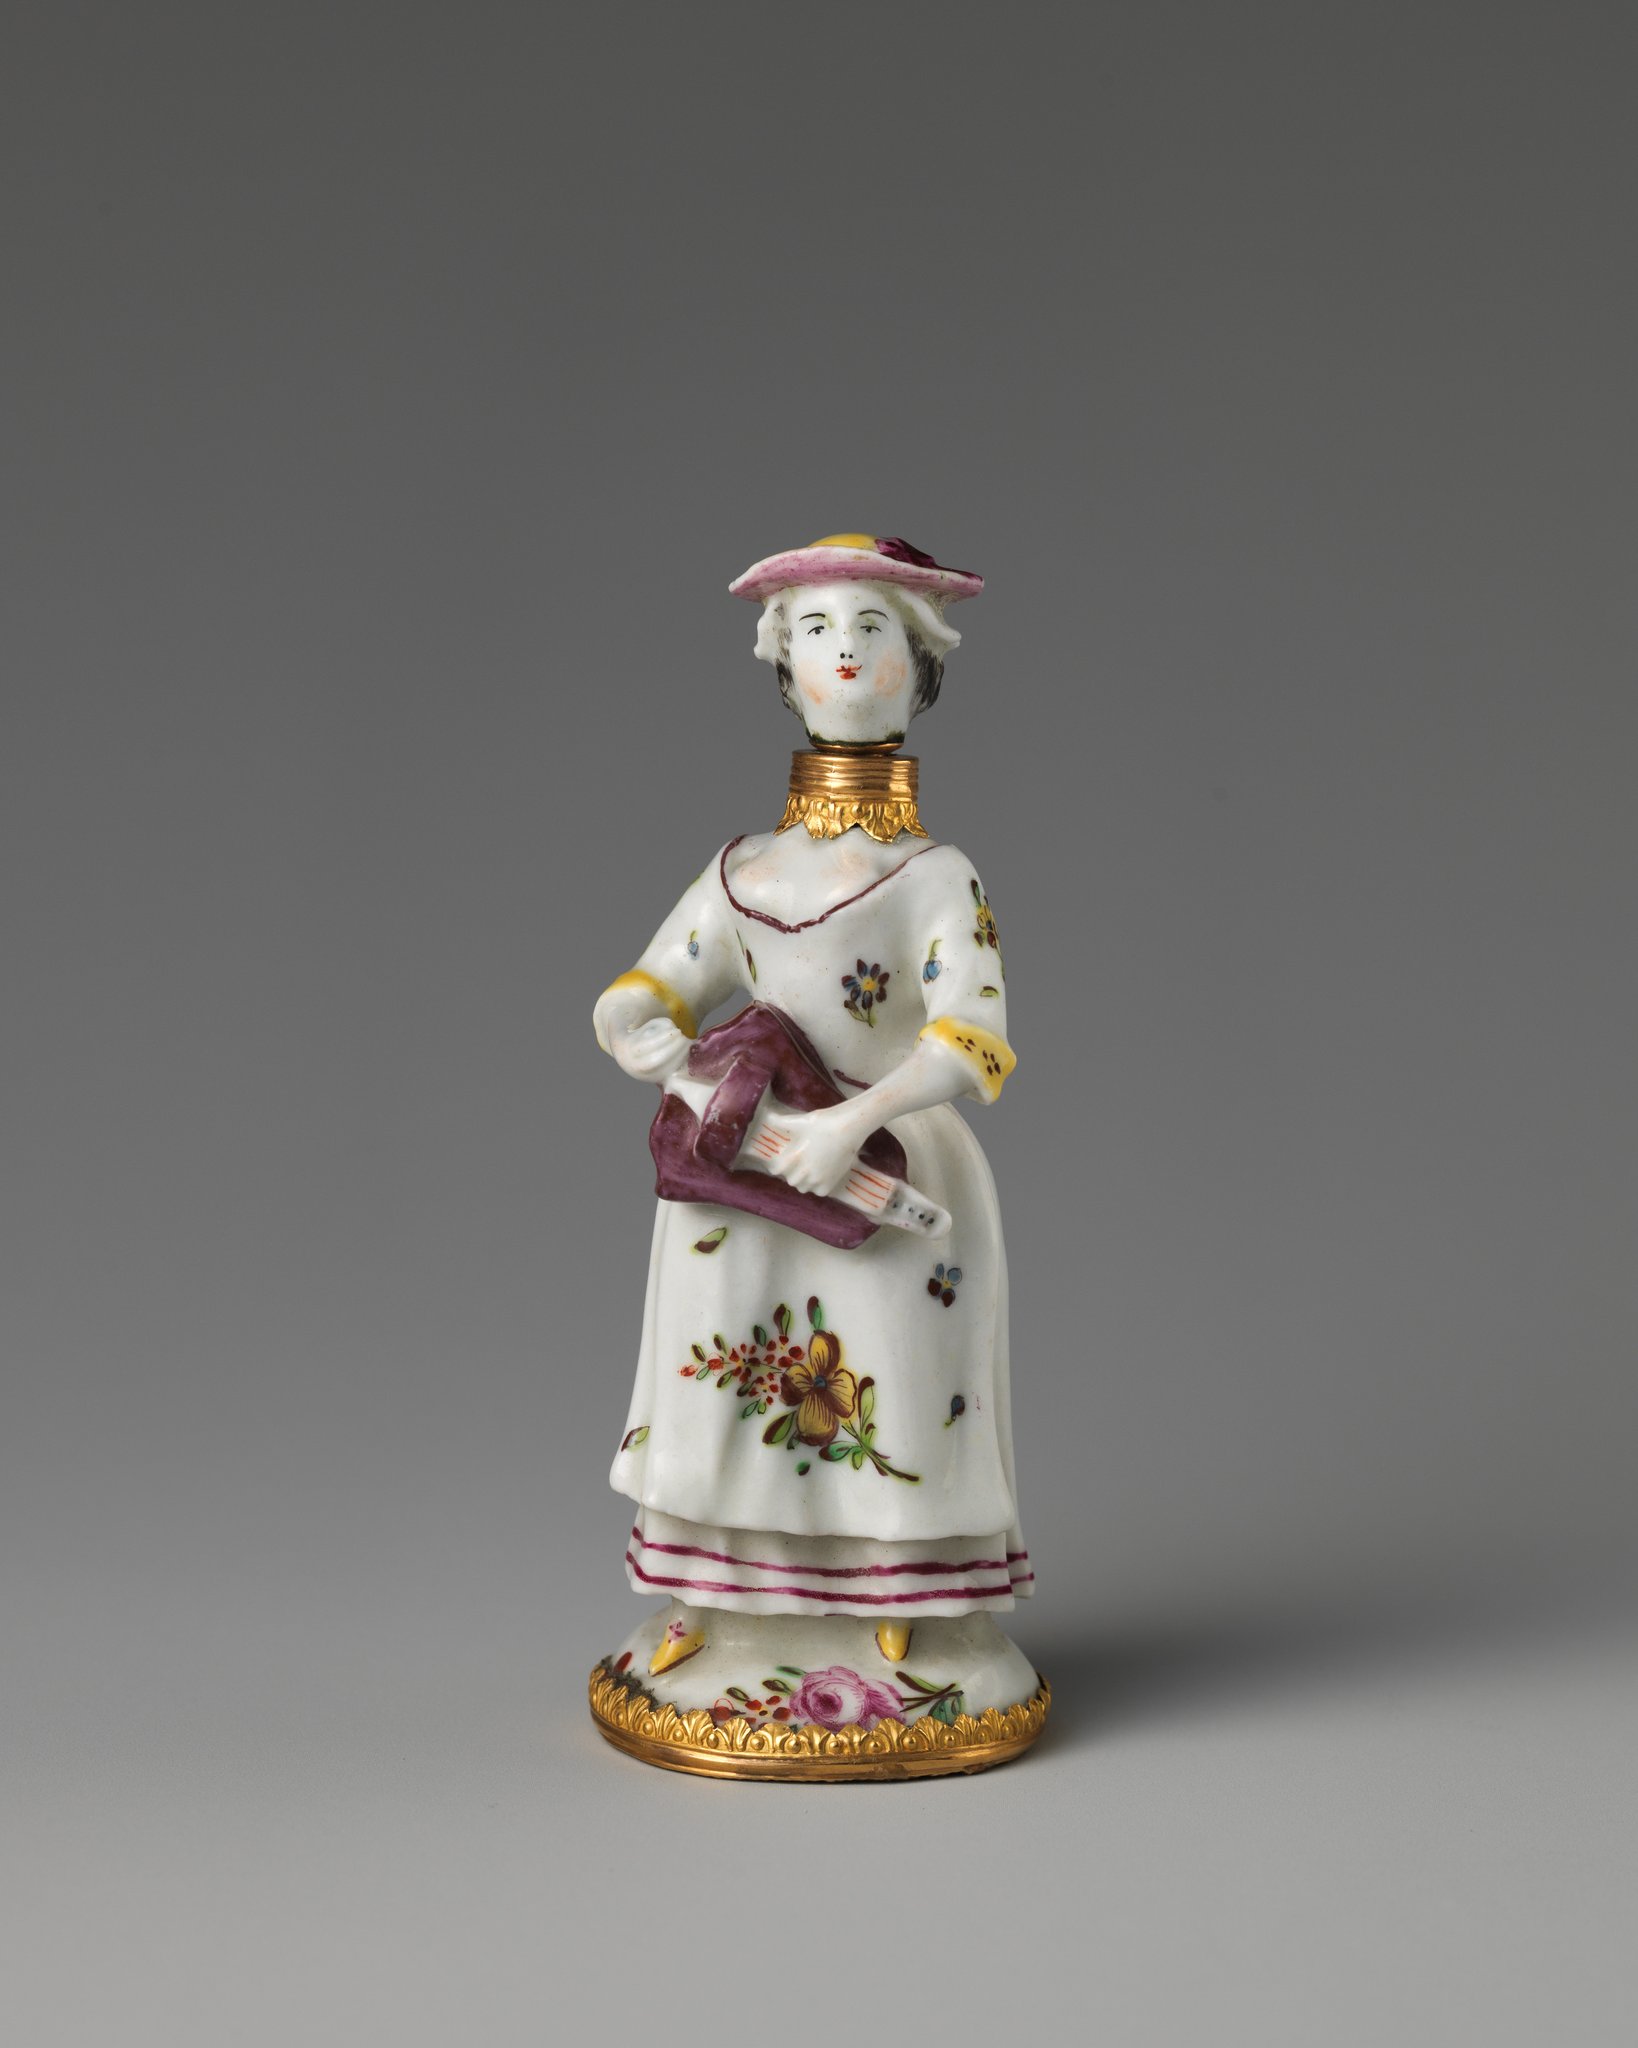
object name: toy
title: Lady with hurdy-gurdy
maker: saint james's factory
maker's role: maker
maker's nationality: british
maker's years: 1749-1759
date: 1750-1755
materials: soft paste porcelain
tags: musical instruments,women,flowers,leaves